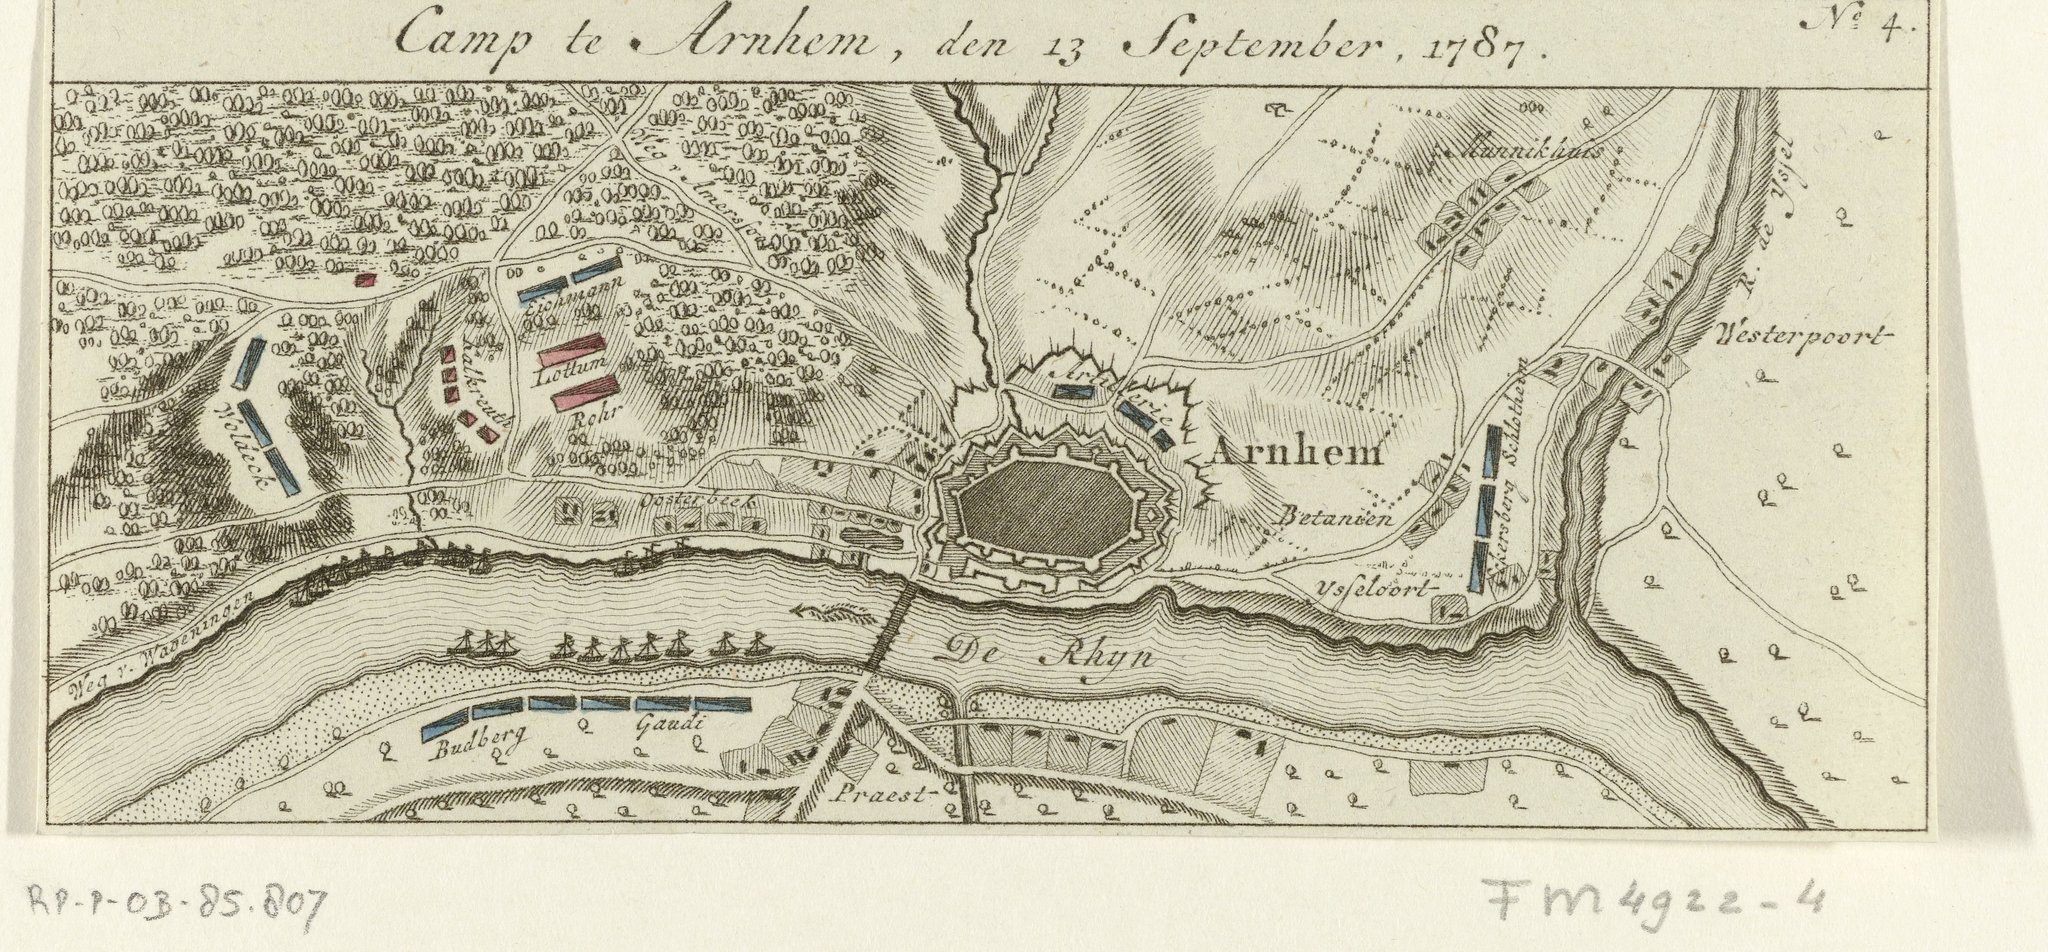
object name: book illustration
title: Kampement van de Pruisen te Arnhem, 1787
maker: Anonymous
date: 1790-1792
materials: paper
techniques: etching, hand coloring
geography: northern netherlands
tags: maps of cities, arnhem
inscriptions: collector's mark: Lugt 2228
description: Kaart met de ligging van het kampement van de Pruisische troepen bij Arnhem op 13 september 1787. Onderdeel van een groep van veertien genummerde kaartjes van de kampementen van de Pruisische troepen tijdens de interventie in de Nederlanden in september 1787.